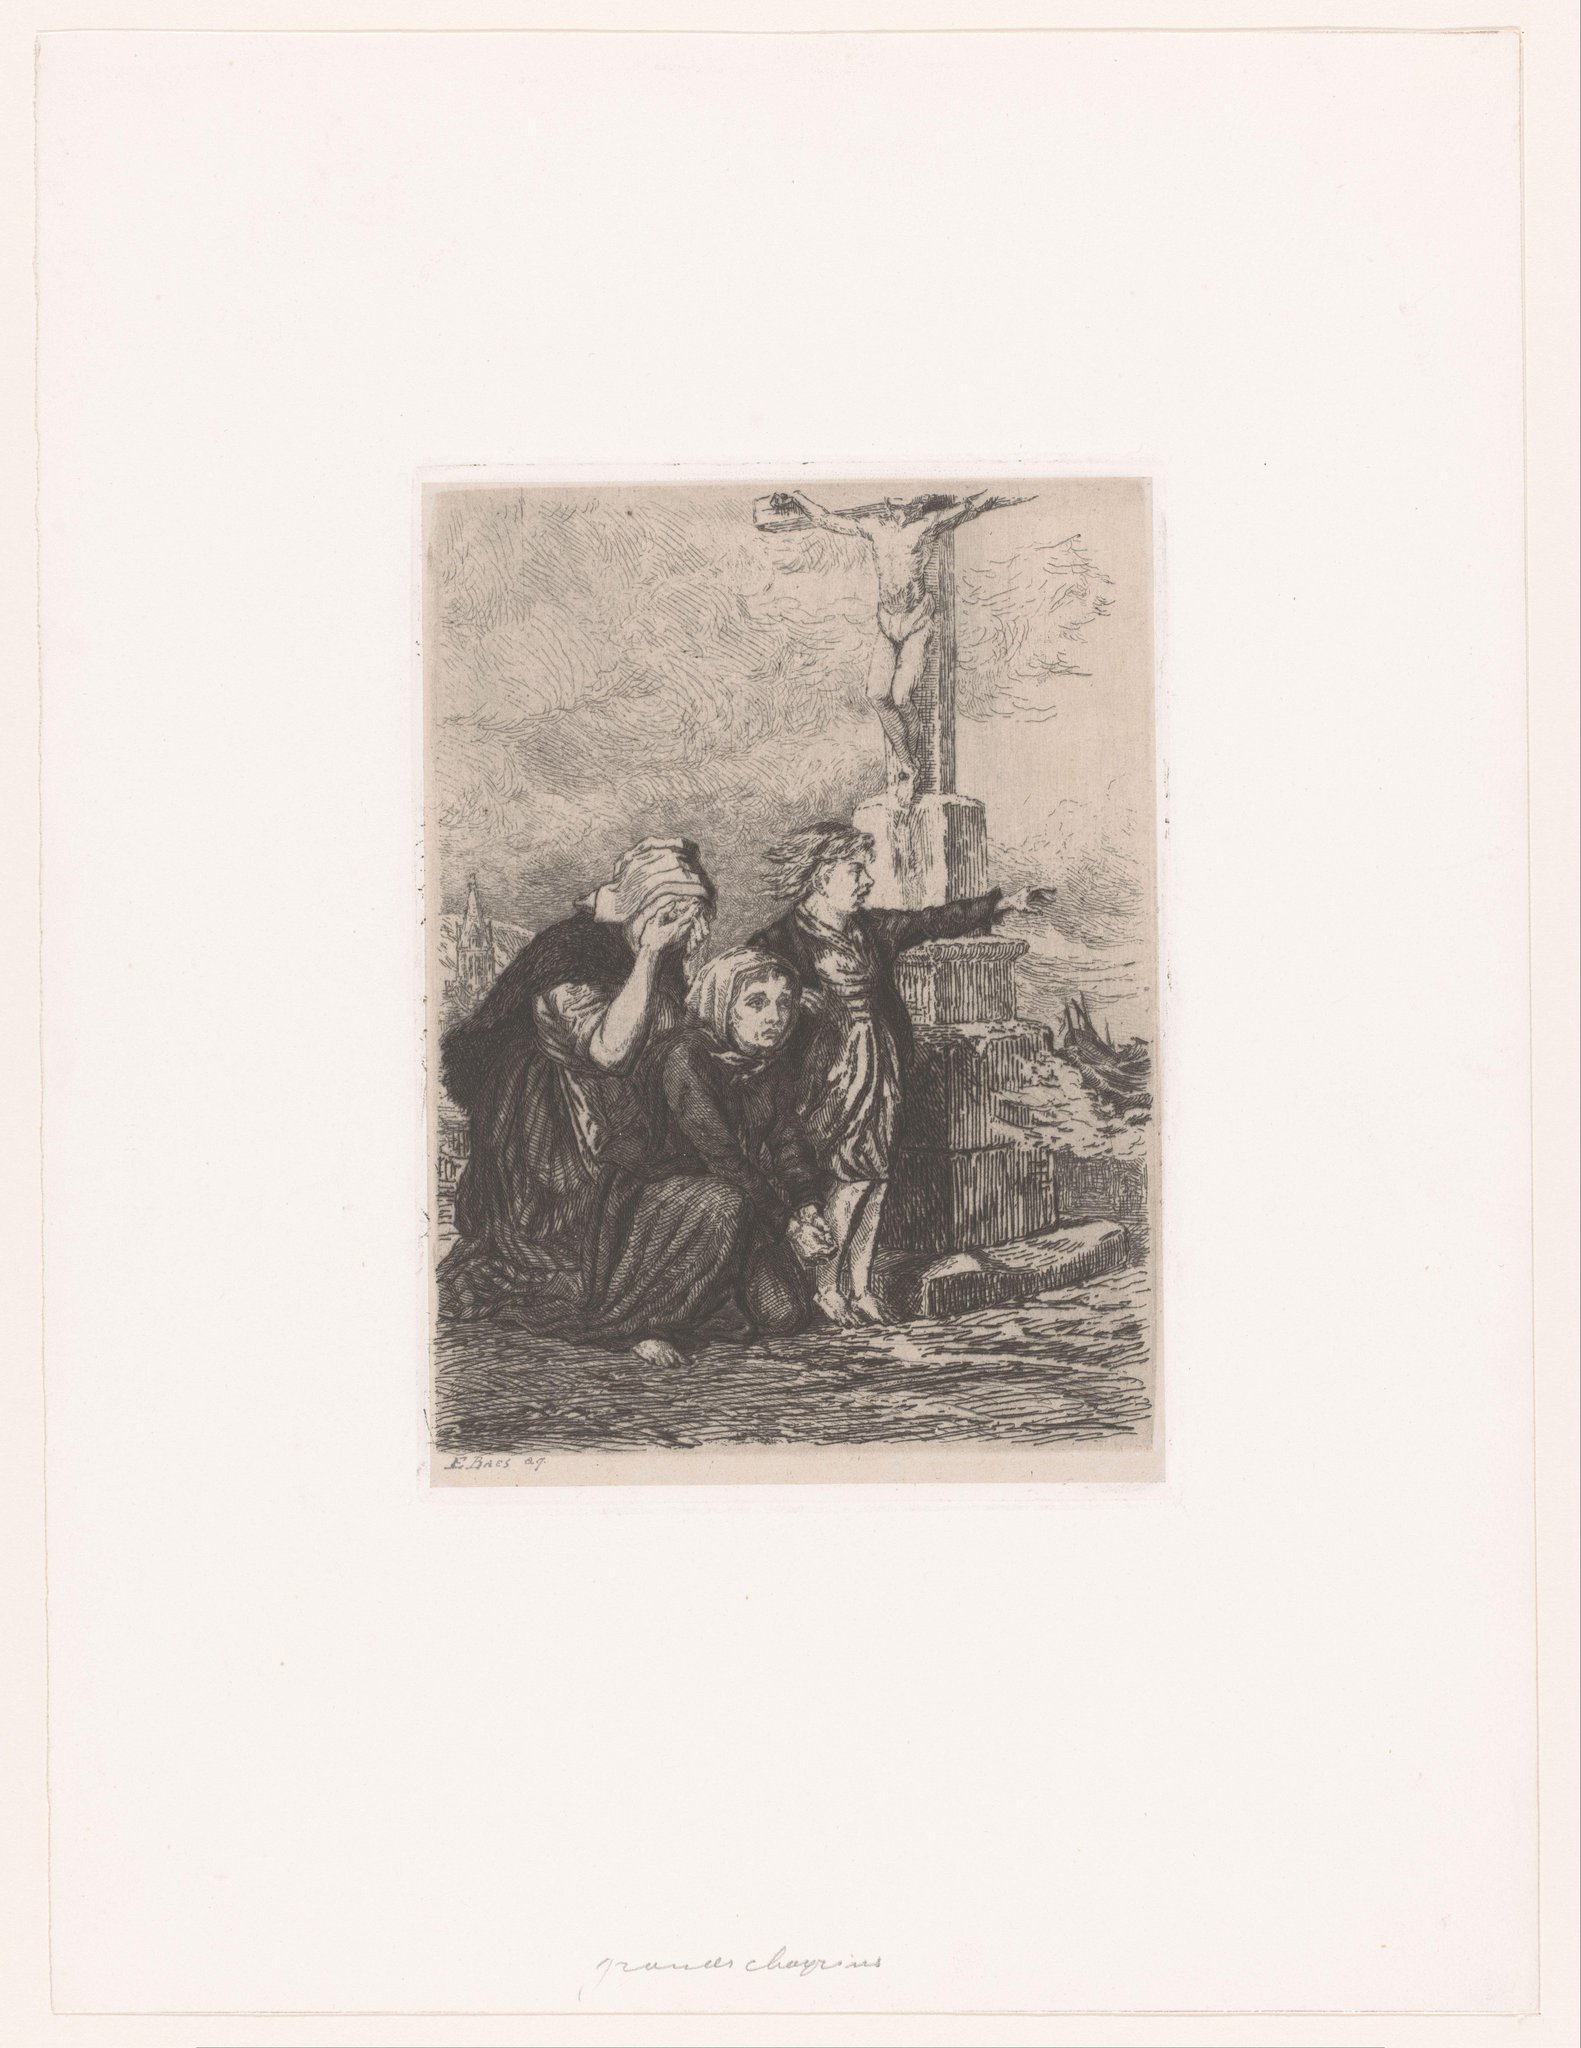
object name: print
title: Vissersvrouwen en een jongen kijken bij een kruisbeeld uit over een stormachtige zee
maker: edgar alfred baes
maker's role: print maker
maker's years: 1837-1909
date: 1847-1909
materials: paper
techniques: drypoint, etching, intaglio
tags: crucifix ~ personal devotion, seaman, weeping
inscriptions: collector's mark: Lugt 2228, annotation: ‘grands chagrins’